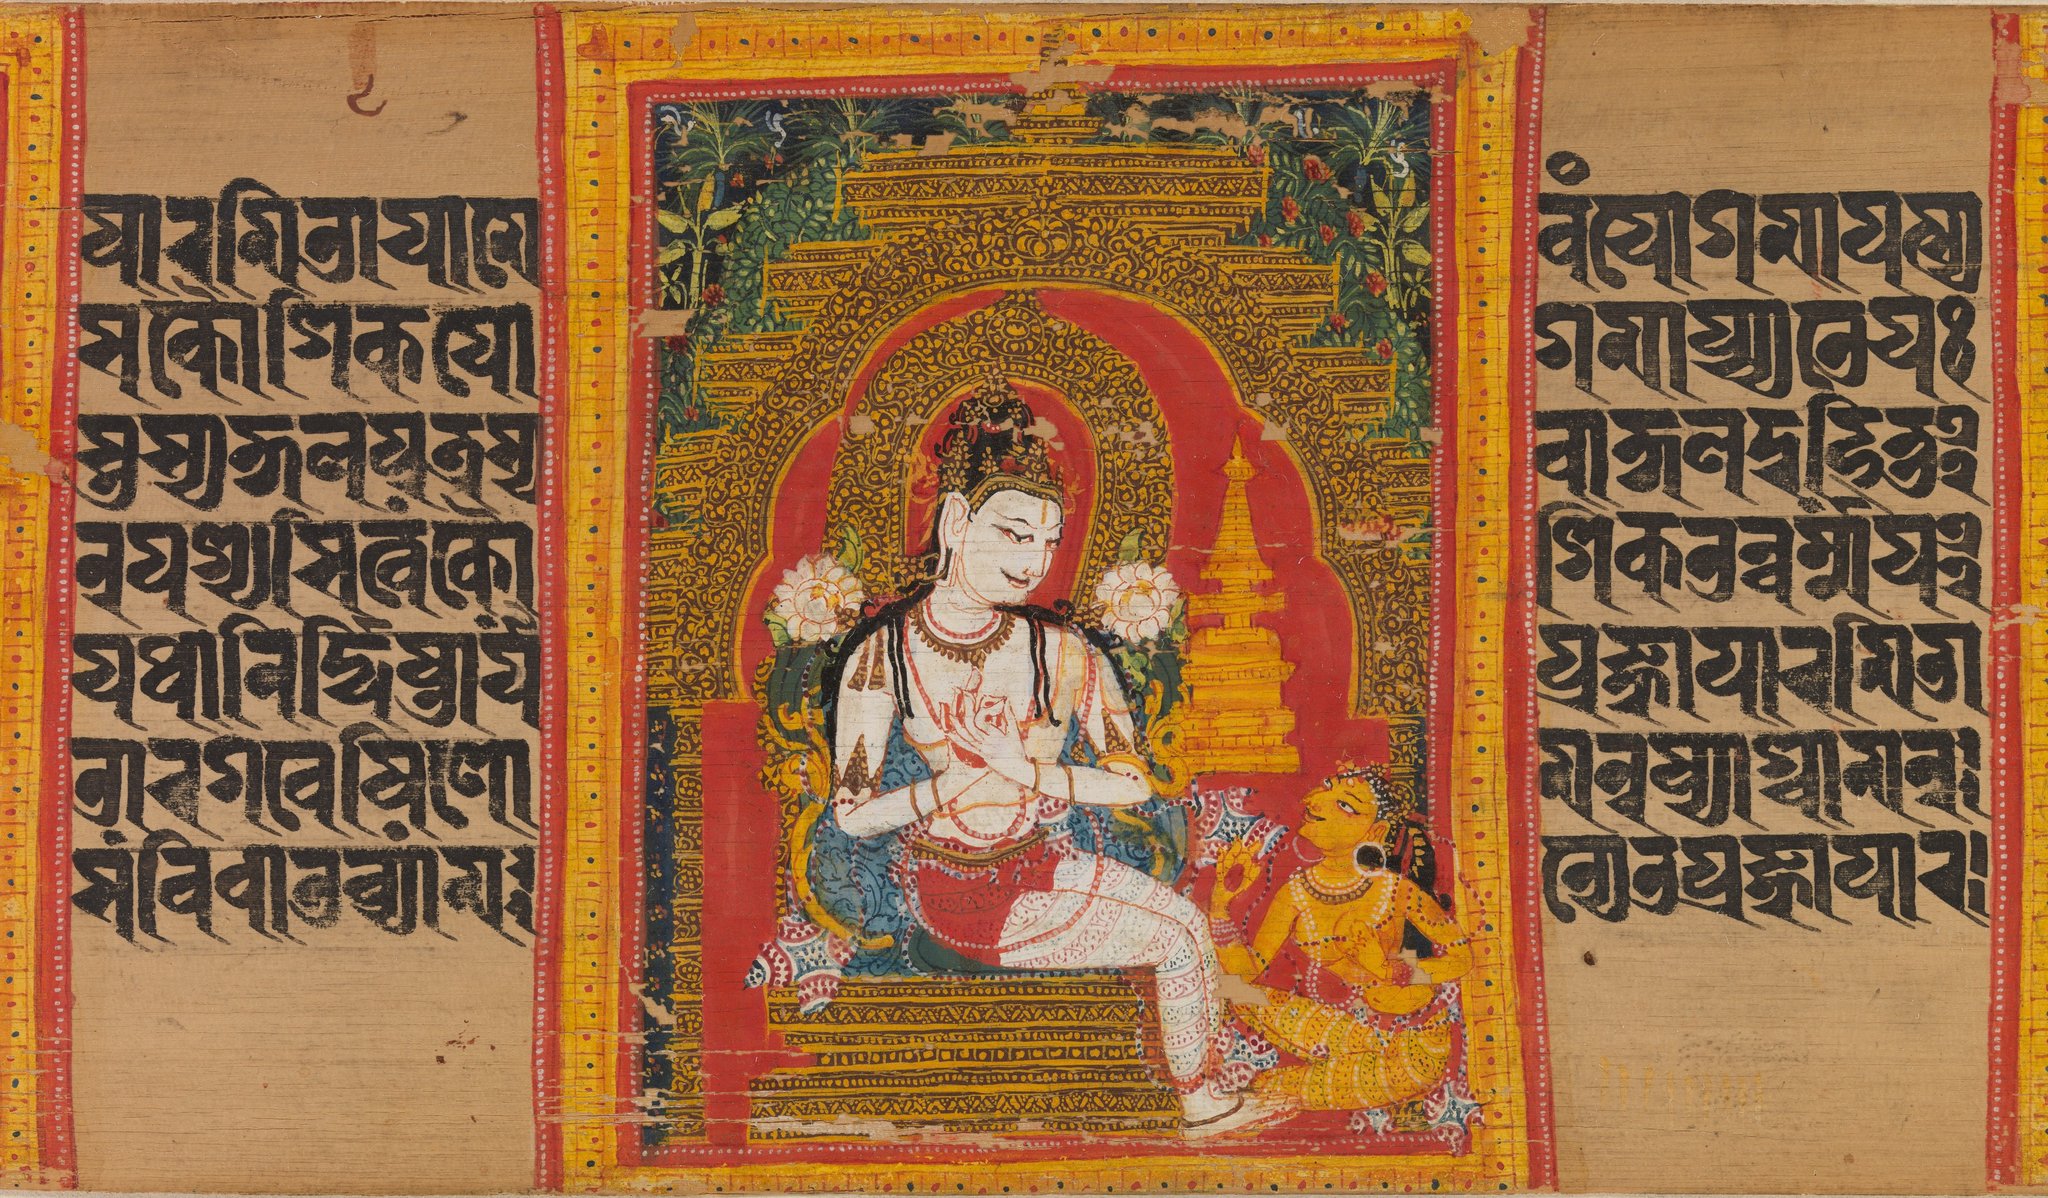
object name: folio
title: The Bodhisattva Avalokitesvara Expounding the Dharma to a Devotee: Folio from a Ashtasahasrika Prajnaparamita Sutra Manuscript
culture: indian or west bengali or bangladeshi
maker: mahavihara master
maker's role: artist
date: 1101-1133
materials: leaf, watercolor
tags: buddhism,avalokiteshvara,bodhisattvas